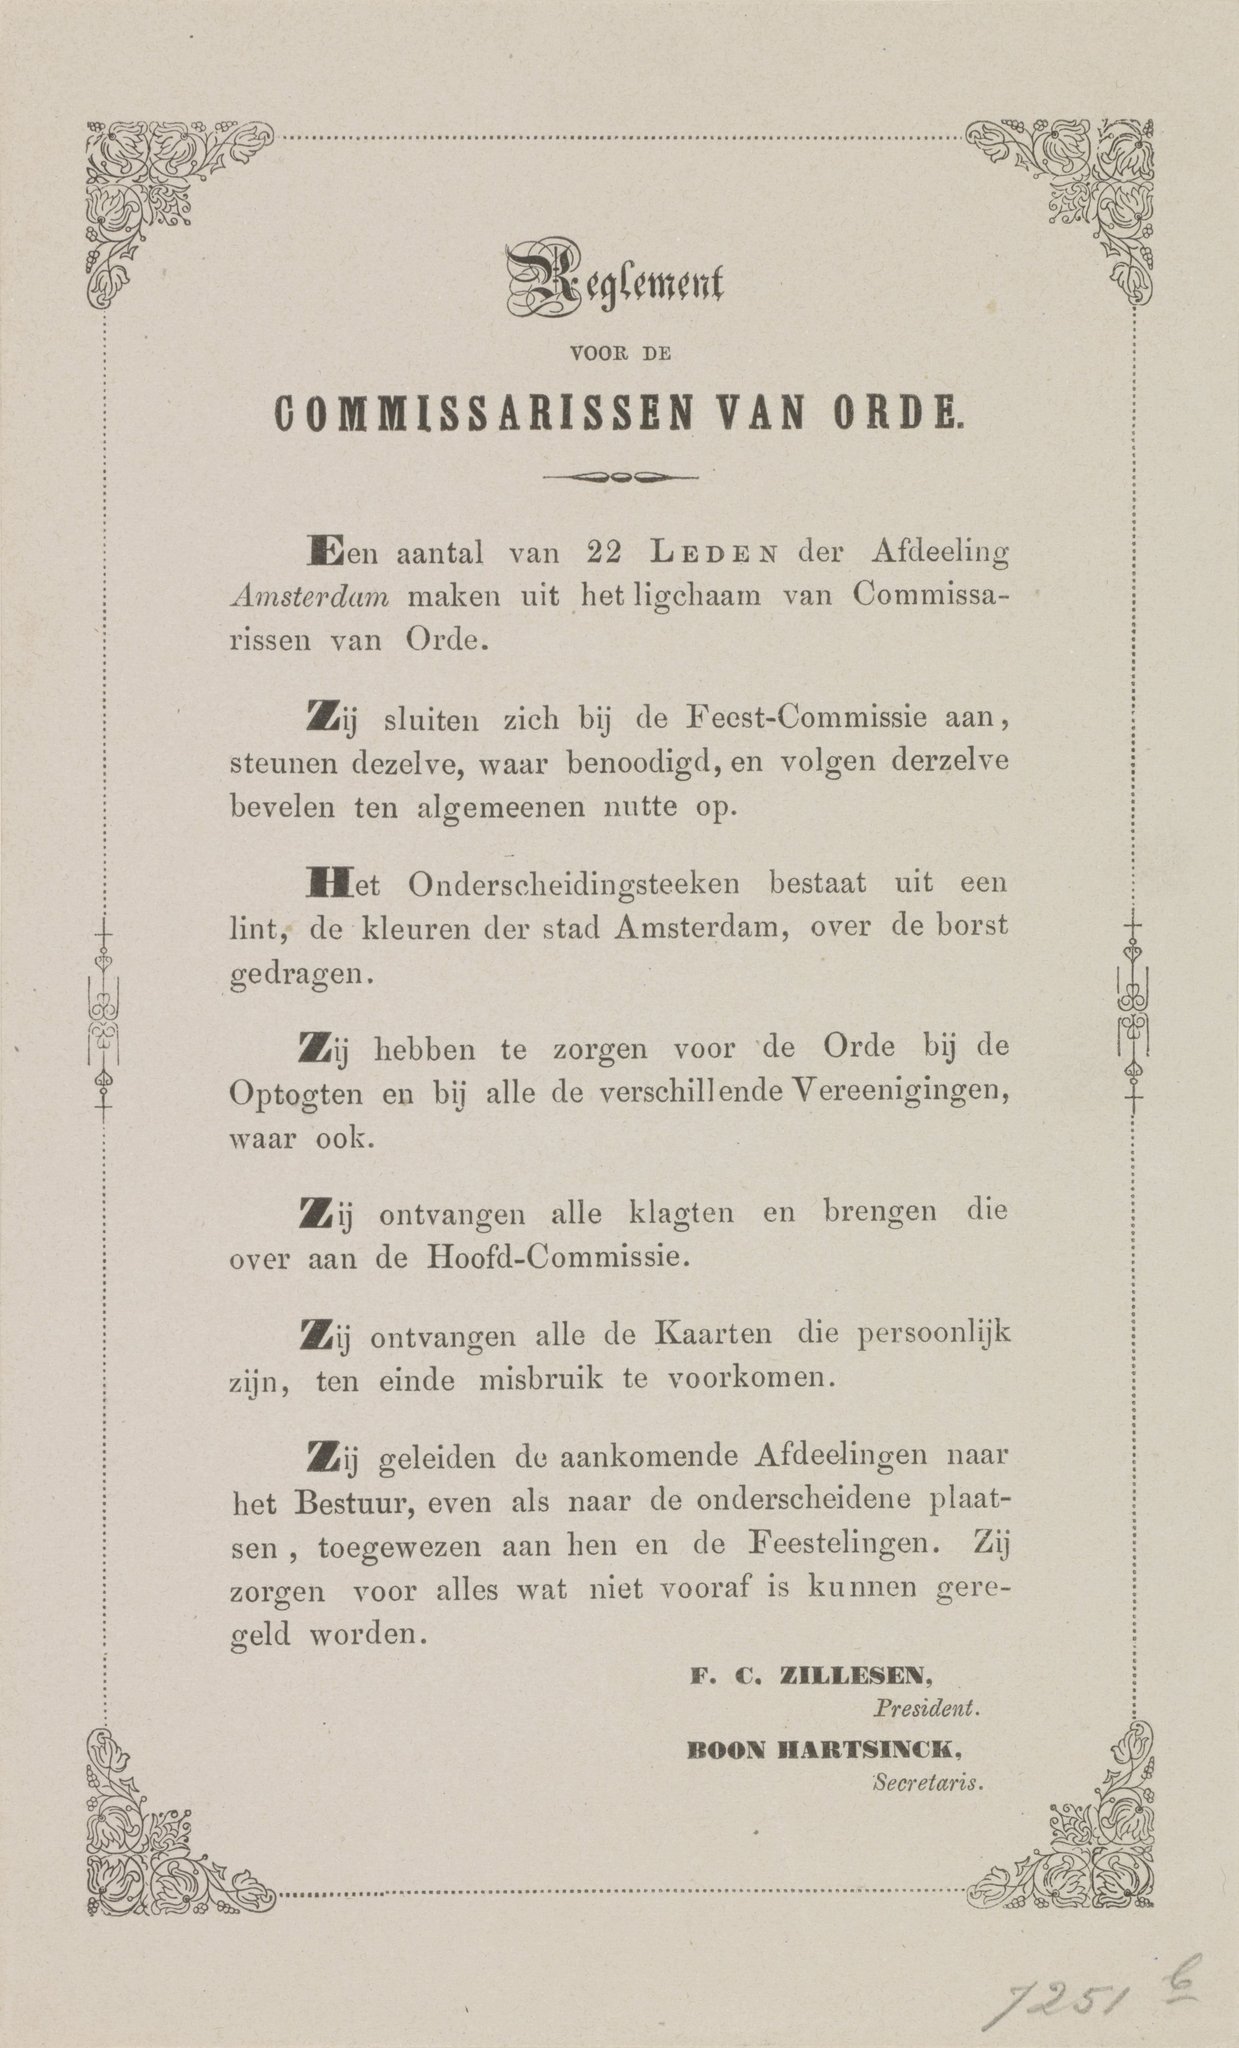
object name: text sheet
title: Reglement voor de Commissarissen van Orde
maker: Anonymous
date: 1856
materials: paper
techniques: letterpress printing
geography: amsterdam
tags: dam, naatje op de dam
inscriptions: collector's mark: Lugt 2228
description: Tekstblad met het reglement voor de Commissarissen van Orde tijdens de onthulling van het monument Gedenkteken aan de Volksgeest van 1830 en 1831, bekend als Naatje op de Dam, onthuld te Amsterdam op 27 augustus 1856. Ondertekend door F.C. Zillesen en Boon Hartsinck.